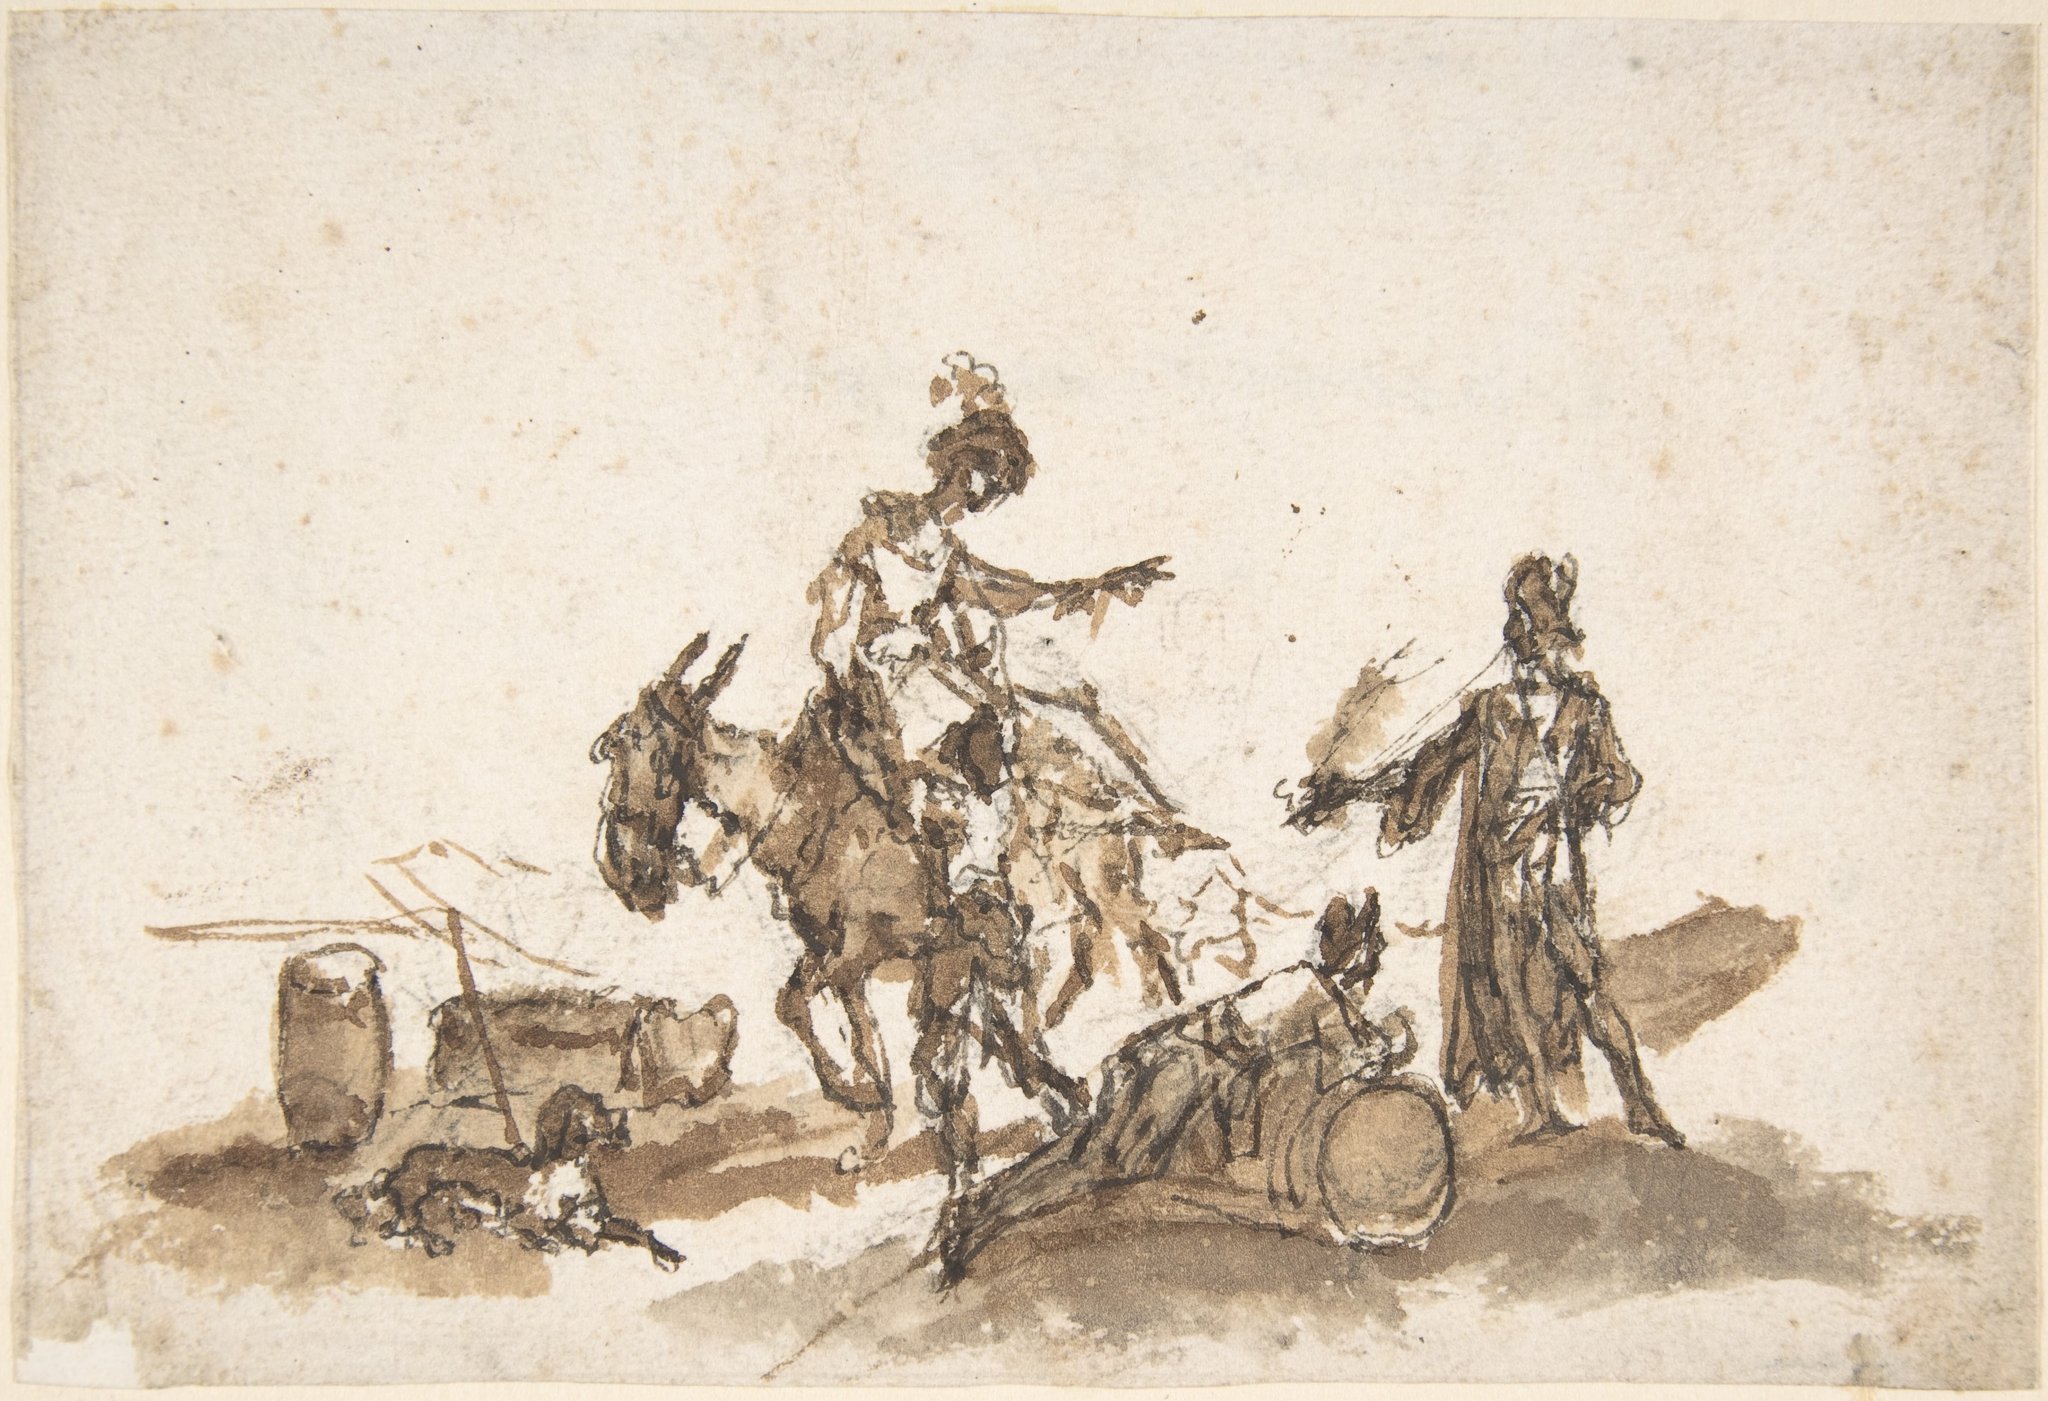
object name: drawing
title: Man Assisting a Woman to Mount a Horse, with Two Other Figures and a Dog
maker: giuseppe bernardino bison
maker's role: artist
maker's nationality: italian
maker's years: 1762-1844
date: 1762-1844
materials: chalk, ink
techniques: brush, pen, wash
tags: men,women,dogs,horses